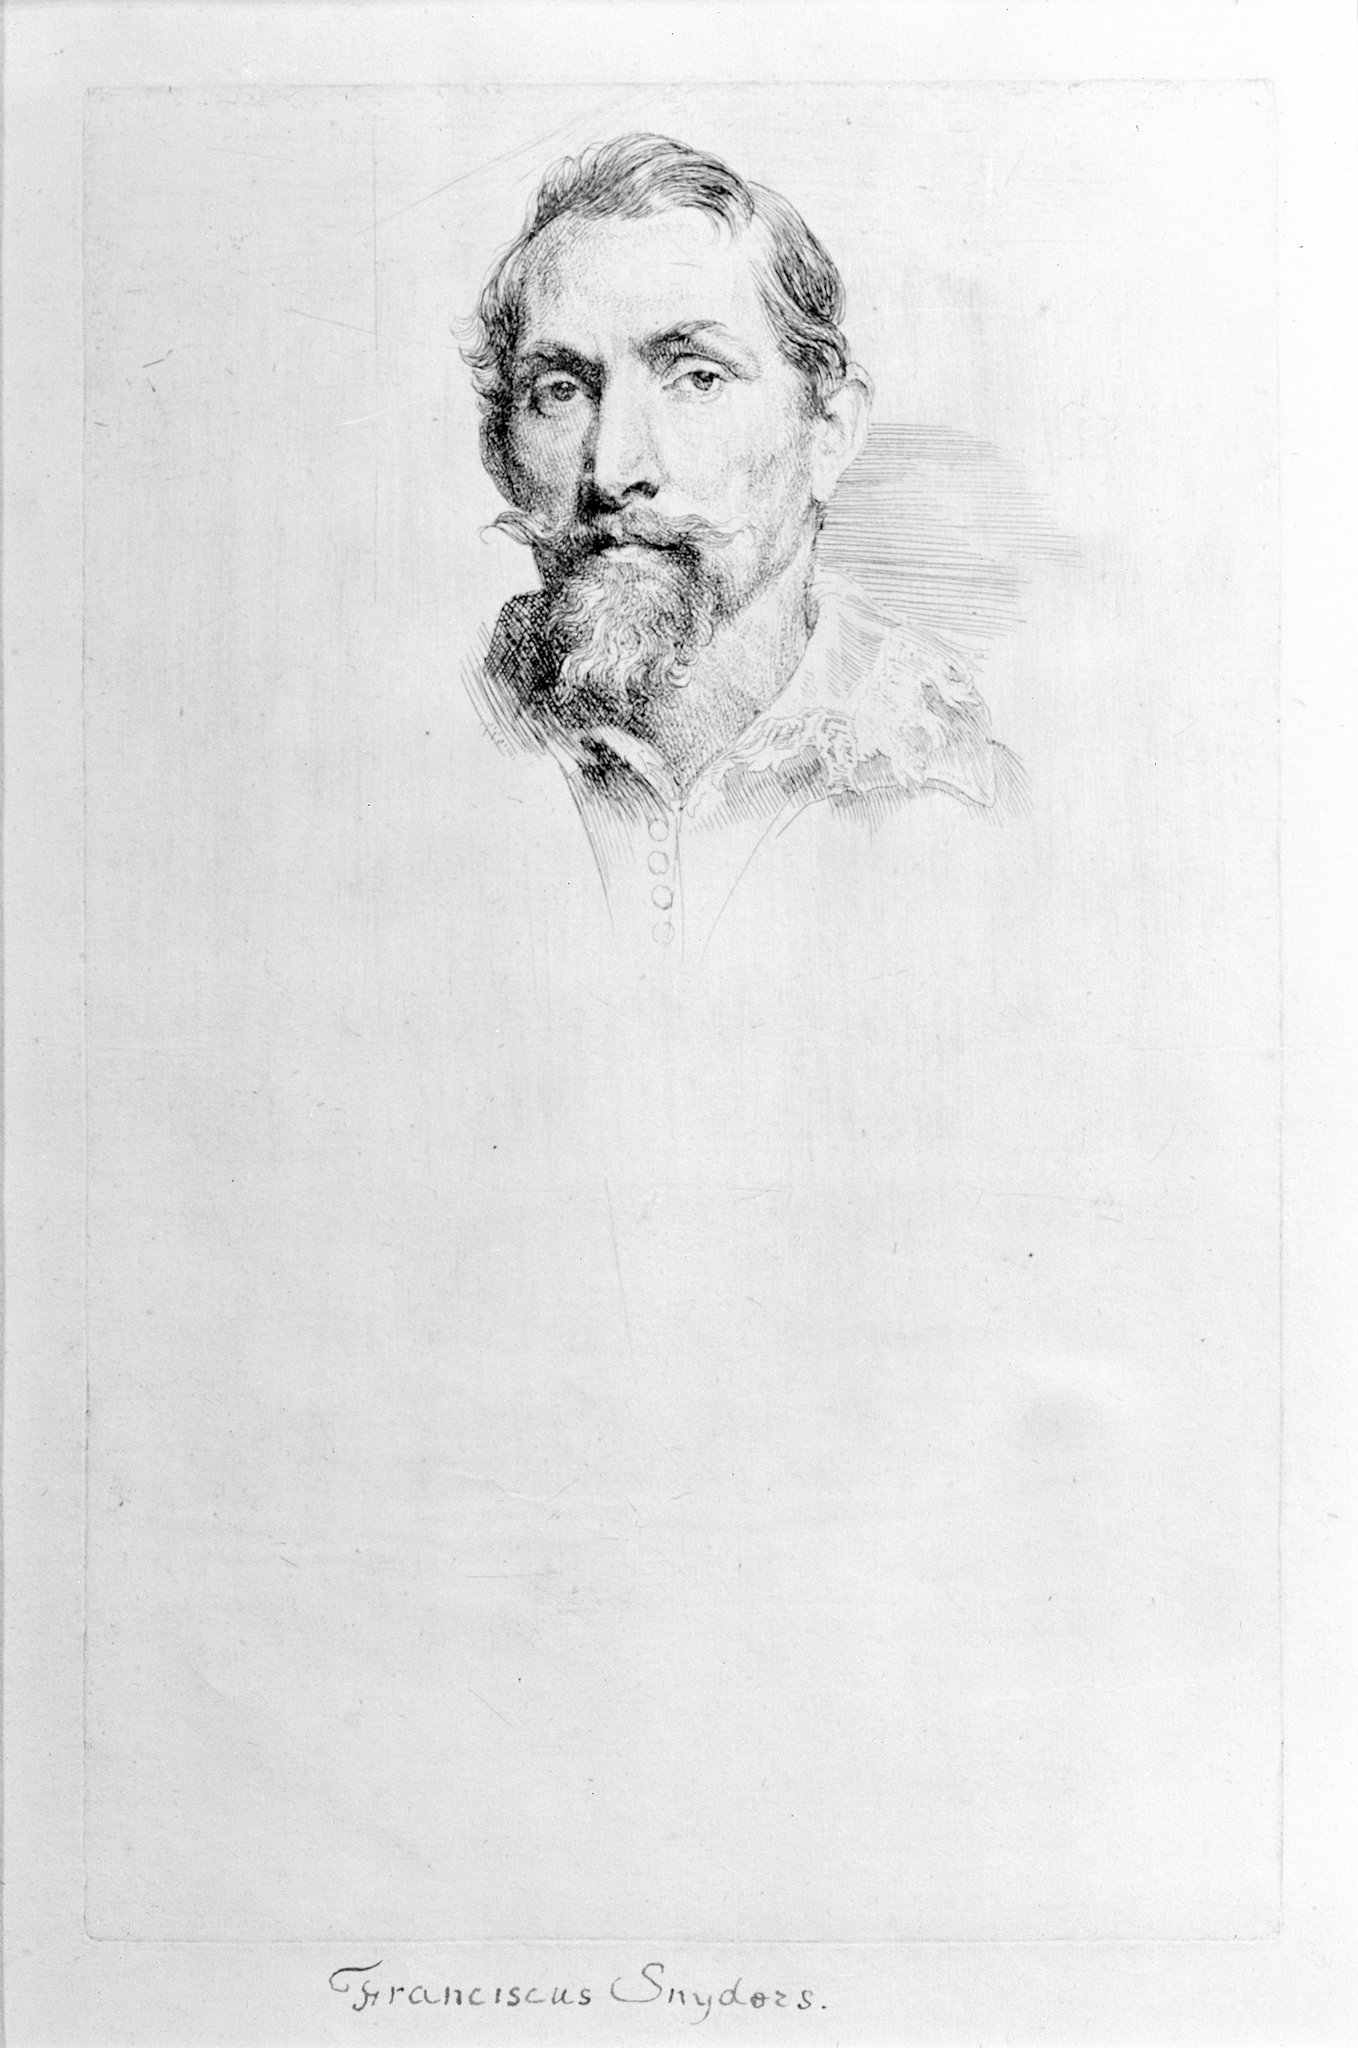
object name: print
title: Frans Snyders, from "The Iconography"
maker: anthony van dyck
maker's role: artist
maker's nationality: flemish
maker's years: 1599-1641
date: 1601-1633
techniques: etching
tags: men,portraits